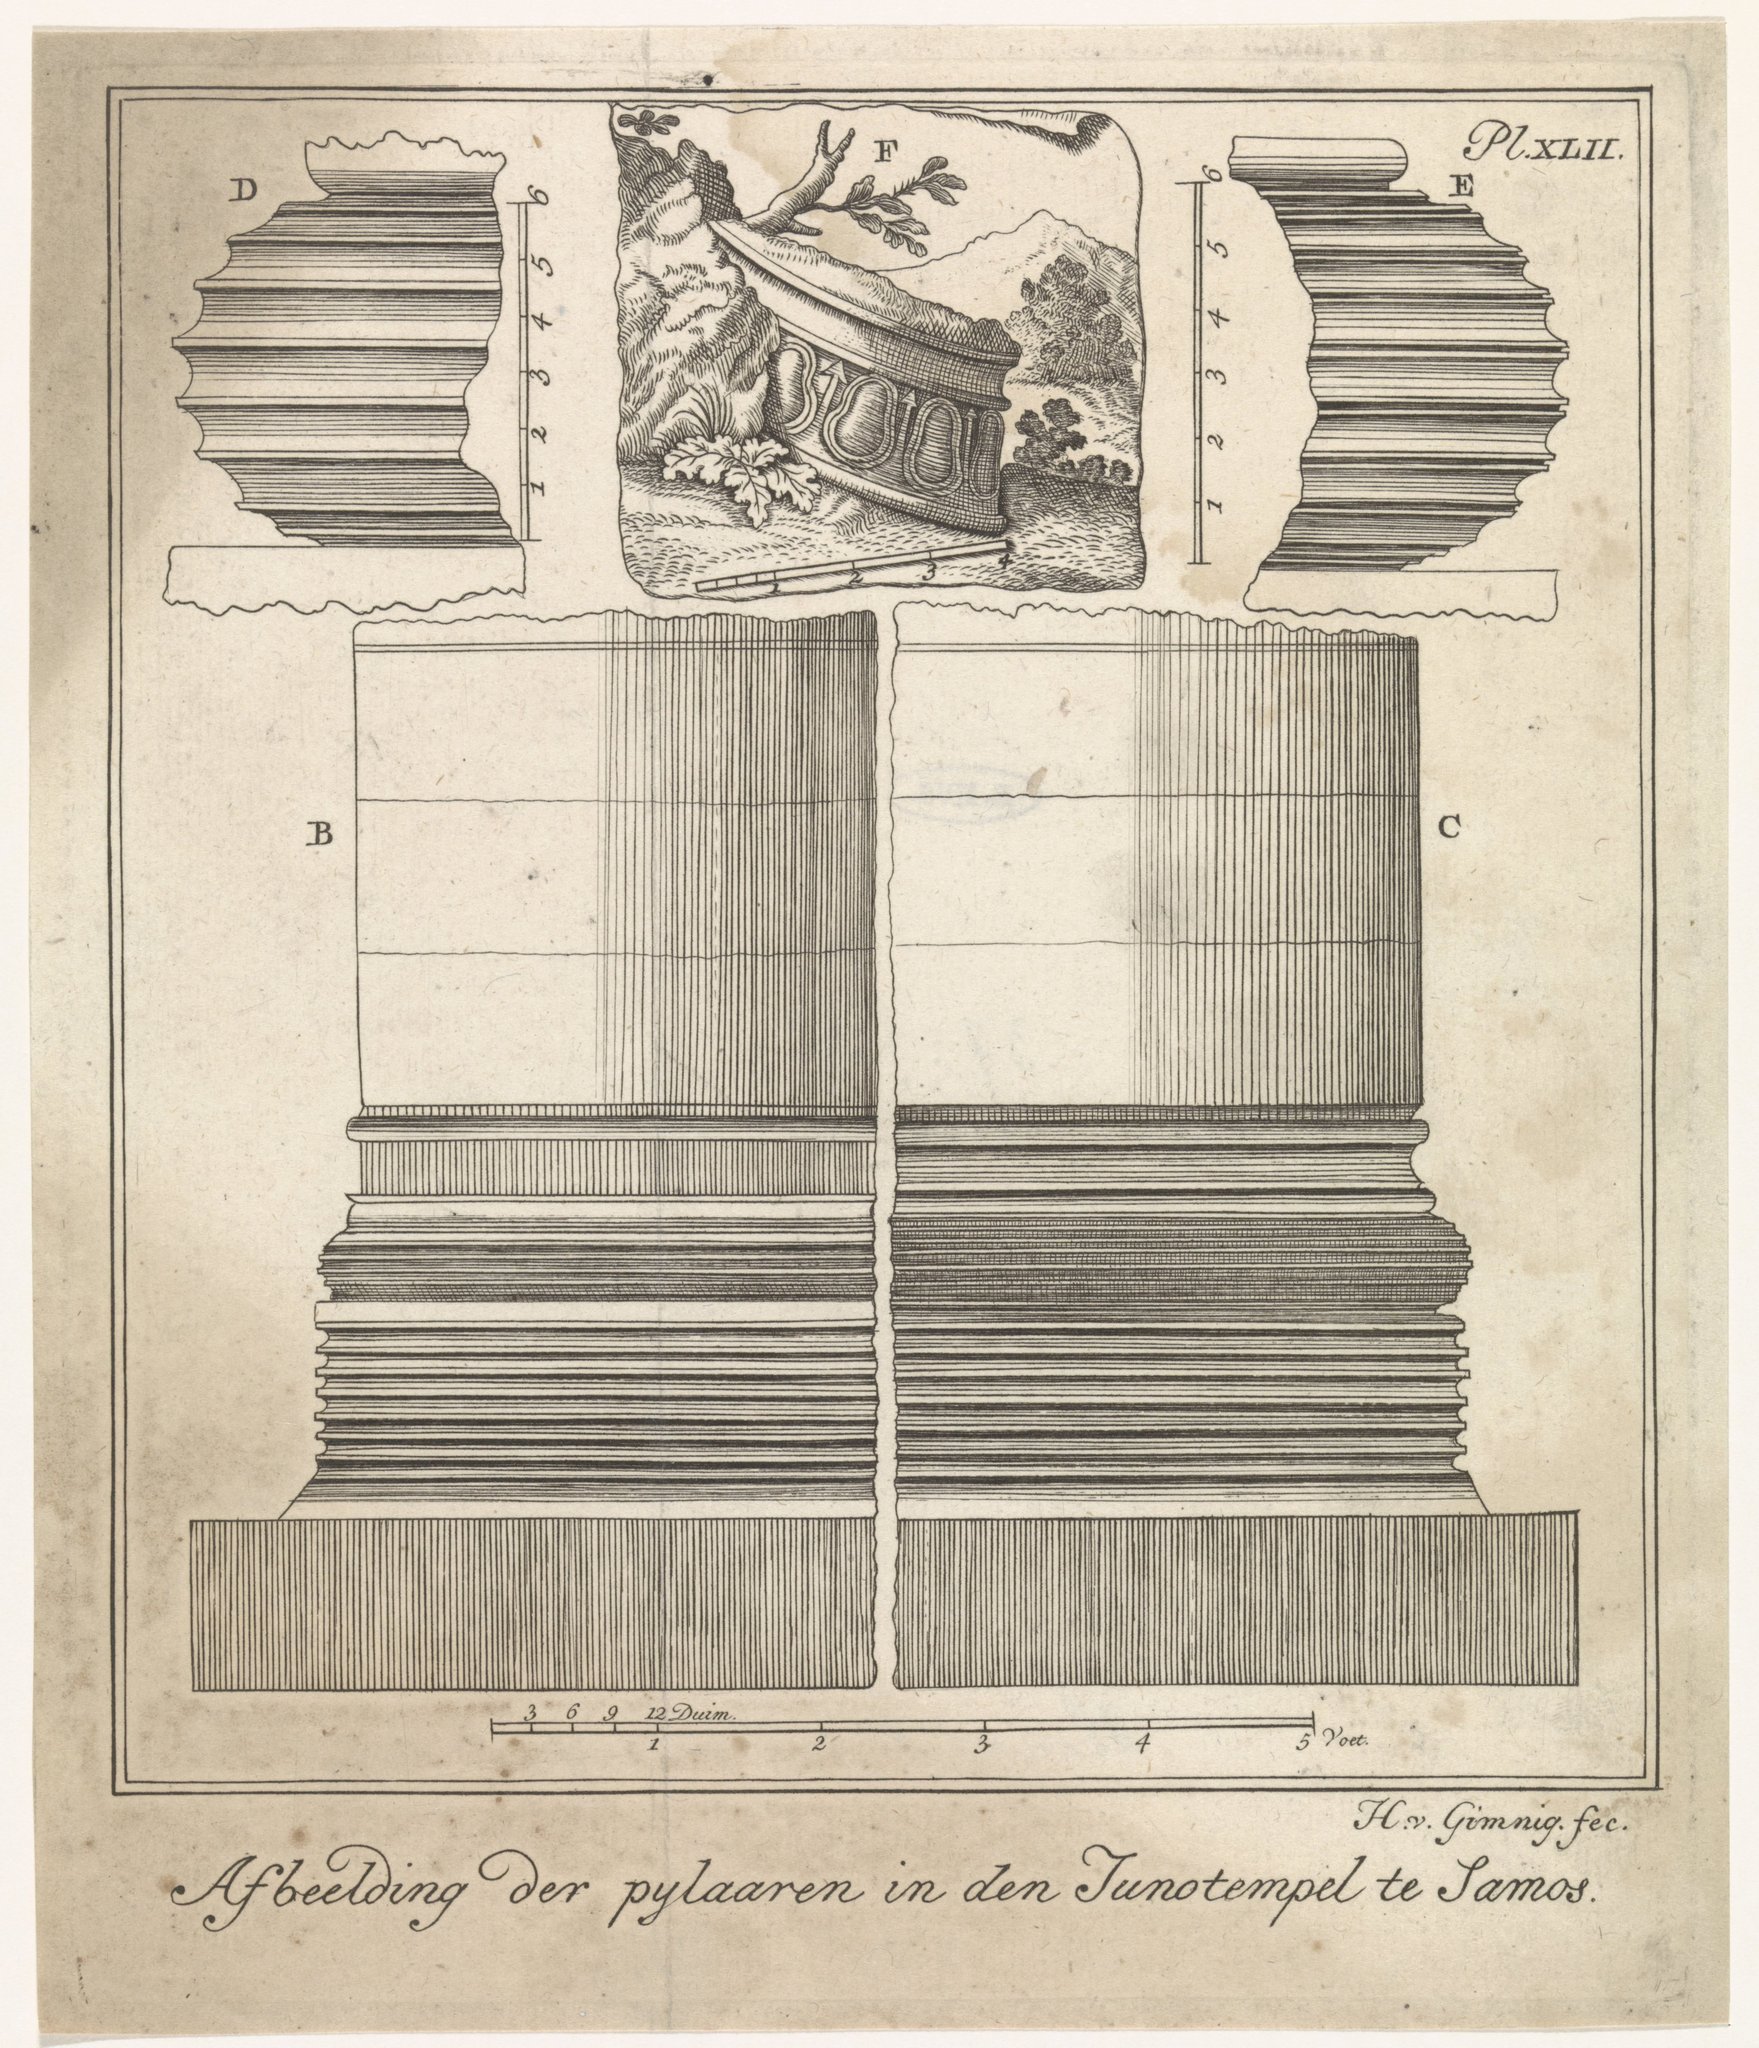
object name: print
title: Studie van de pilaren van de tempel van Juno te Samos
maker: hendrik van gimnig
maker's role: draughtsman, print maker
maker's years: 1700-1800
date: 1720-1780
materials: paper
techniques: engraving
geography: haarlem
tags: (story of) juno (hera), column, pillar ~ architecture, temple, shrine ~ greek religion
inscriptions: collector's mark: Lugt 2228, collector's mark: Lugt 2760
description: Twee pilaren in zijaanzicht met schaalverdeling. Links en rechts bovenaan twee pilaren in doorsnede met schaal. Centraal bovenaan de restanten van een klassieke tempelpilaar. De pilaren zijn volgens de prent van de tempel van Juno te Samos. Rechts in de bovenhoek genummerd plaat XLII.